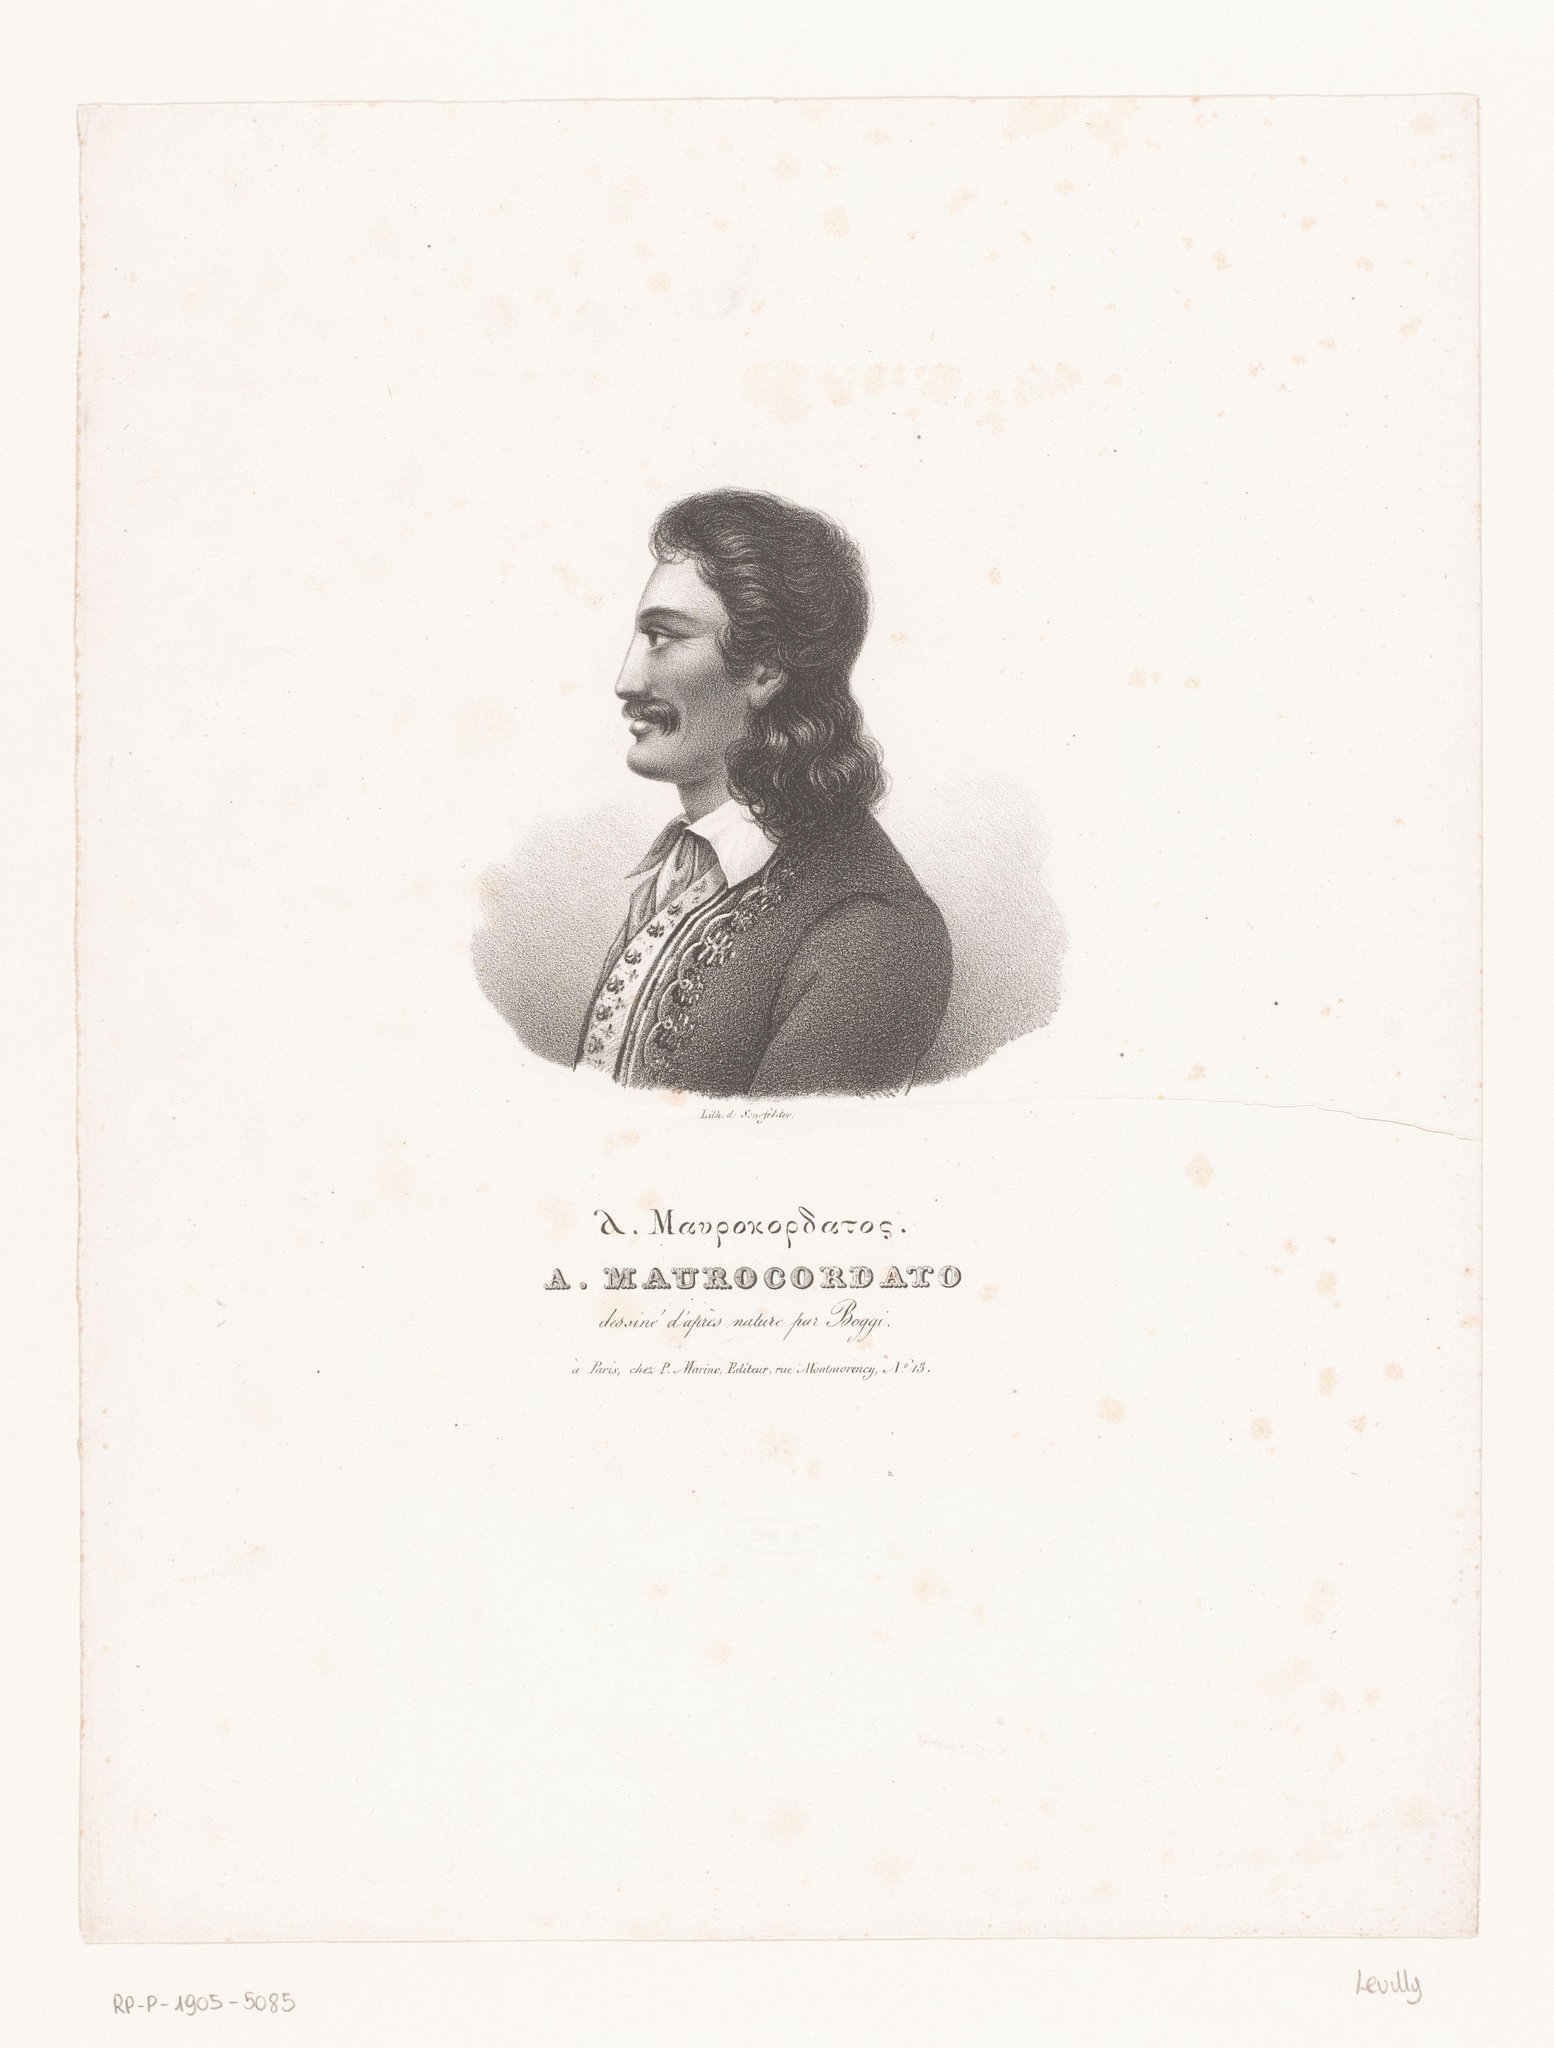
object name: print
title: A. Maurocordato, dessiné d'après nature par Boggi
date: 1827-1829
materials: paper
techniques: lithograph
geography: paris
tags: historical persons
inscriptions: collector's mark: Lugt 2228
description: Mogelijke toeschrijving aan Lévilly op basis van vergelijkbare prenten uit zijn oeuvre.